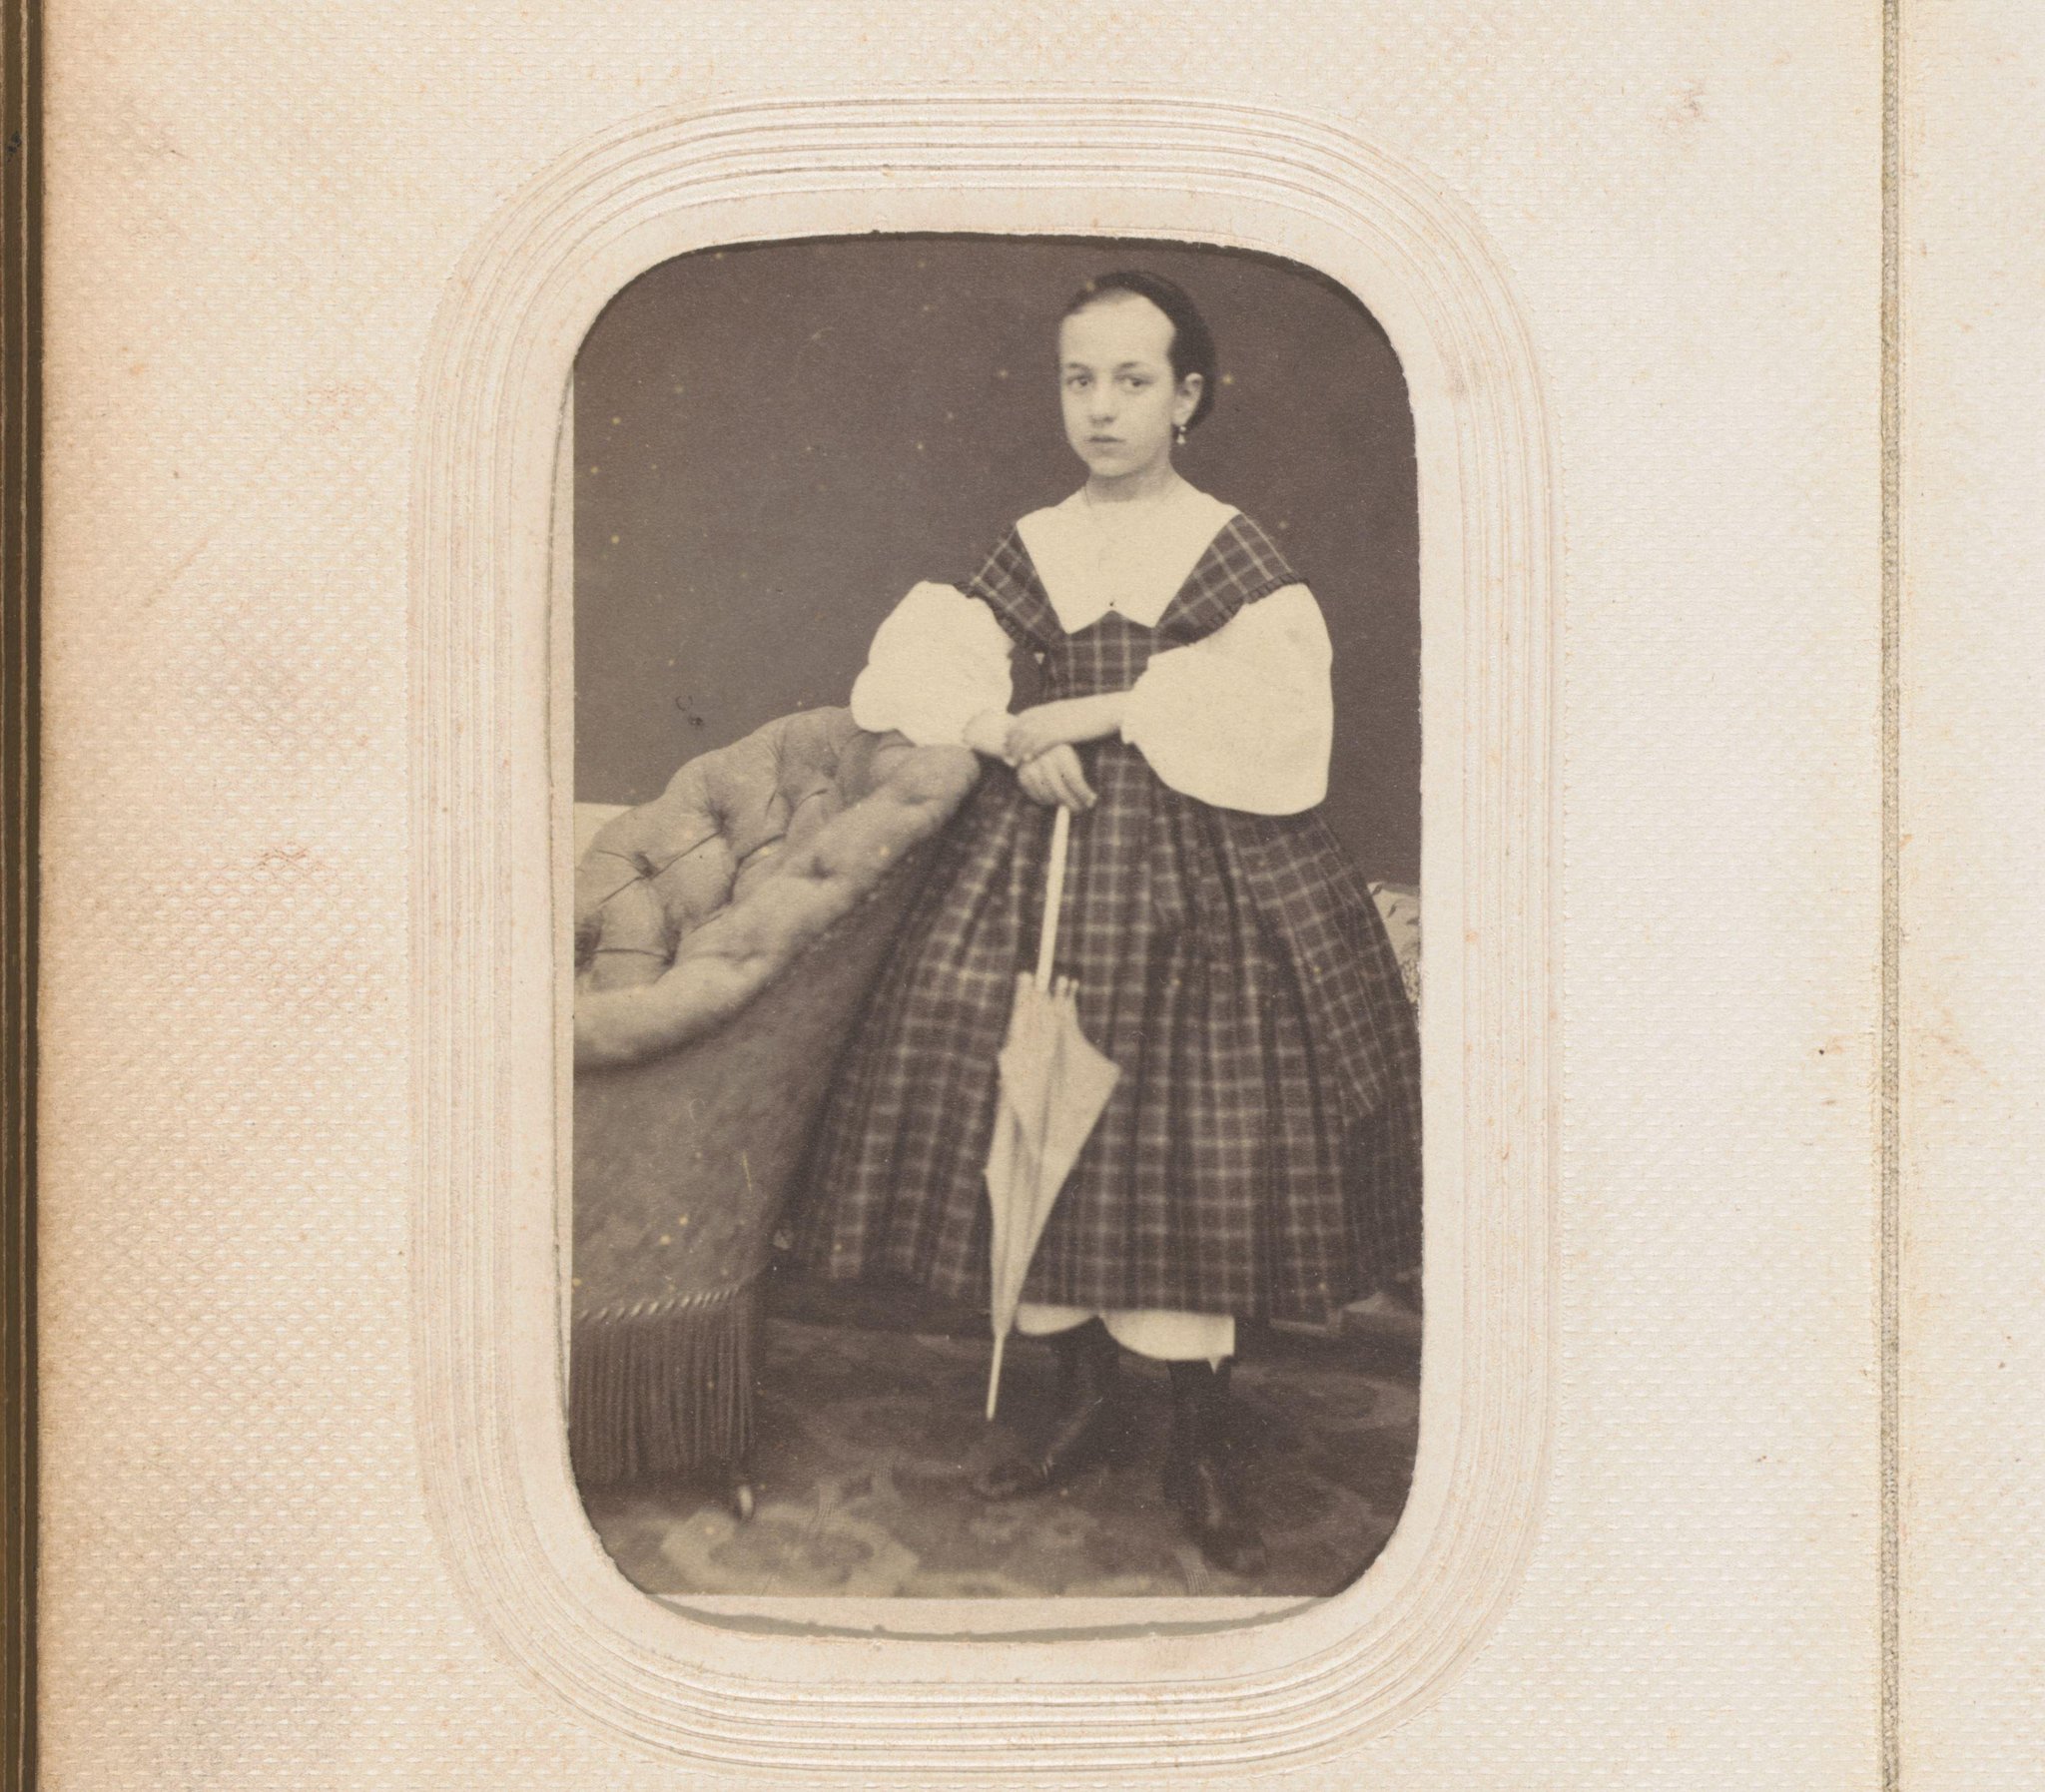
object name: photograph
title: Portret van een staand meisje bij een fauteuil, met parasol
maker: Anonymous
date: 1855-1865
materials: cardboard, photographic support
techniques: albumen print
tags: historical persons, girl (child between toddler and youth), umbrella, chair